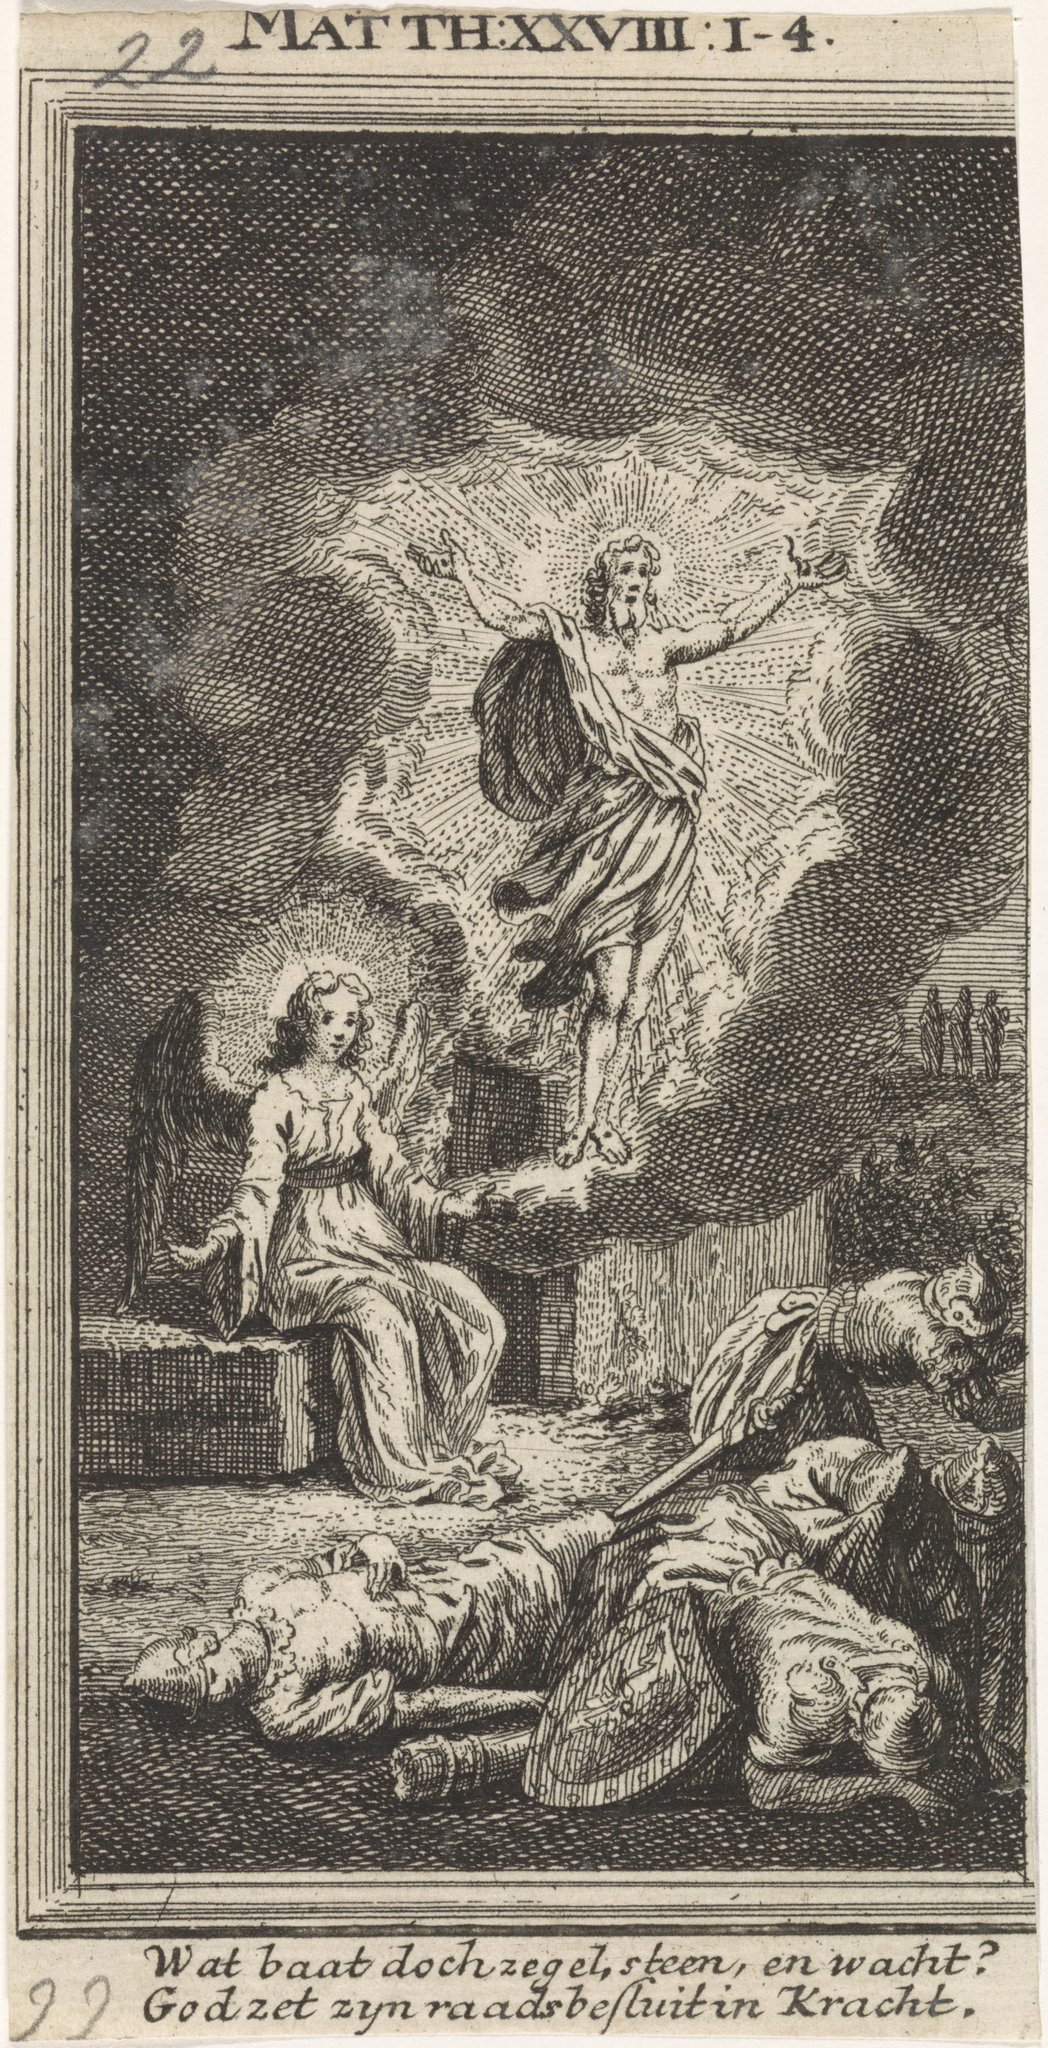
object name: print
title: Opstanding van Christus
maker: Anonymous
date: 1712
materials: paper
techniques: etching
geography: amsterdam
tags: comprehensive representations of the events on golgotha during christ's hanging on the cross, no particular event emphasized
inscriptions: collector's mark: Lugt 2228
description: Kopie naar illustratie voor: Luyken, Jan. Bybel printen. Amsterdam: Pieter Arentsz. II (wed.) en Cornelis van der Sys, 1712, p. 22.